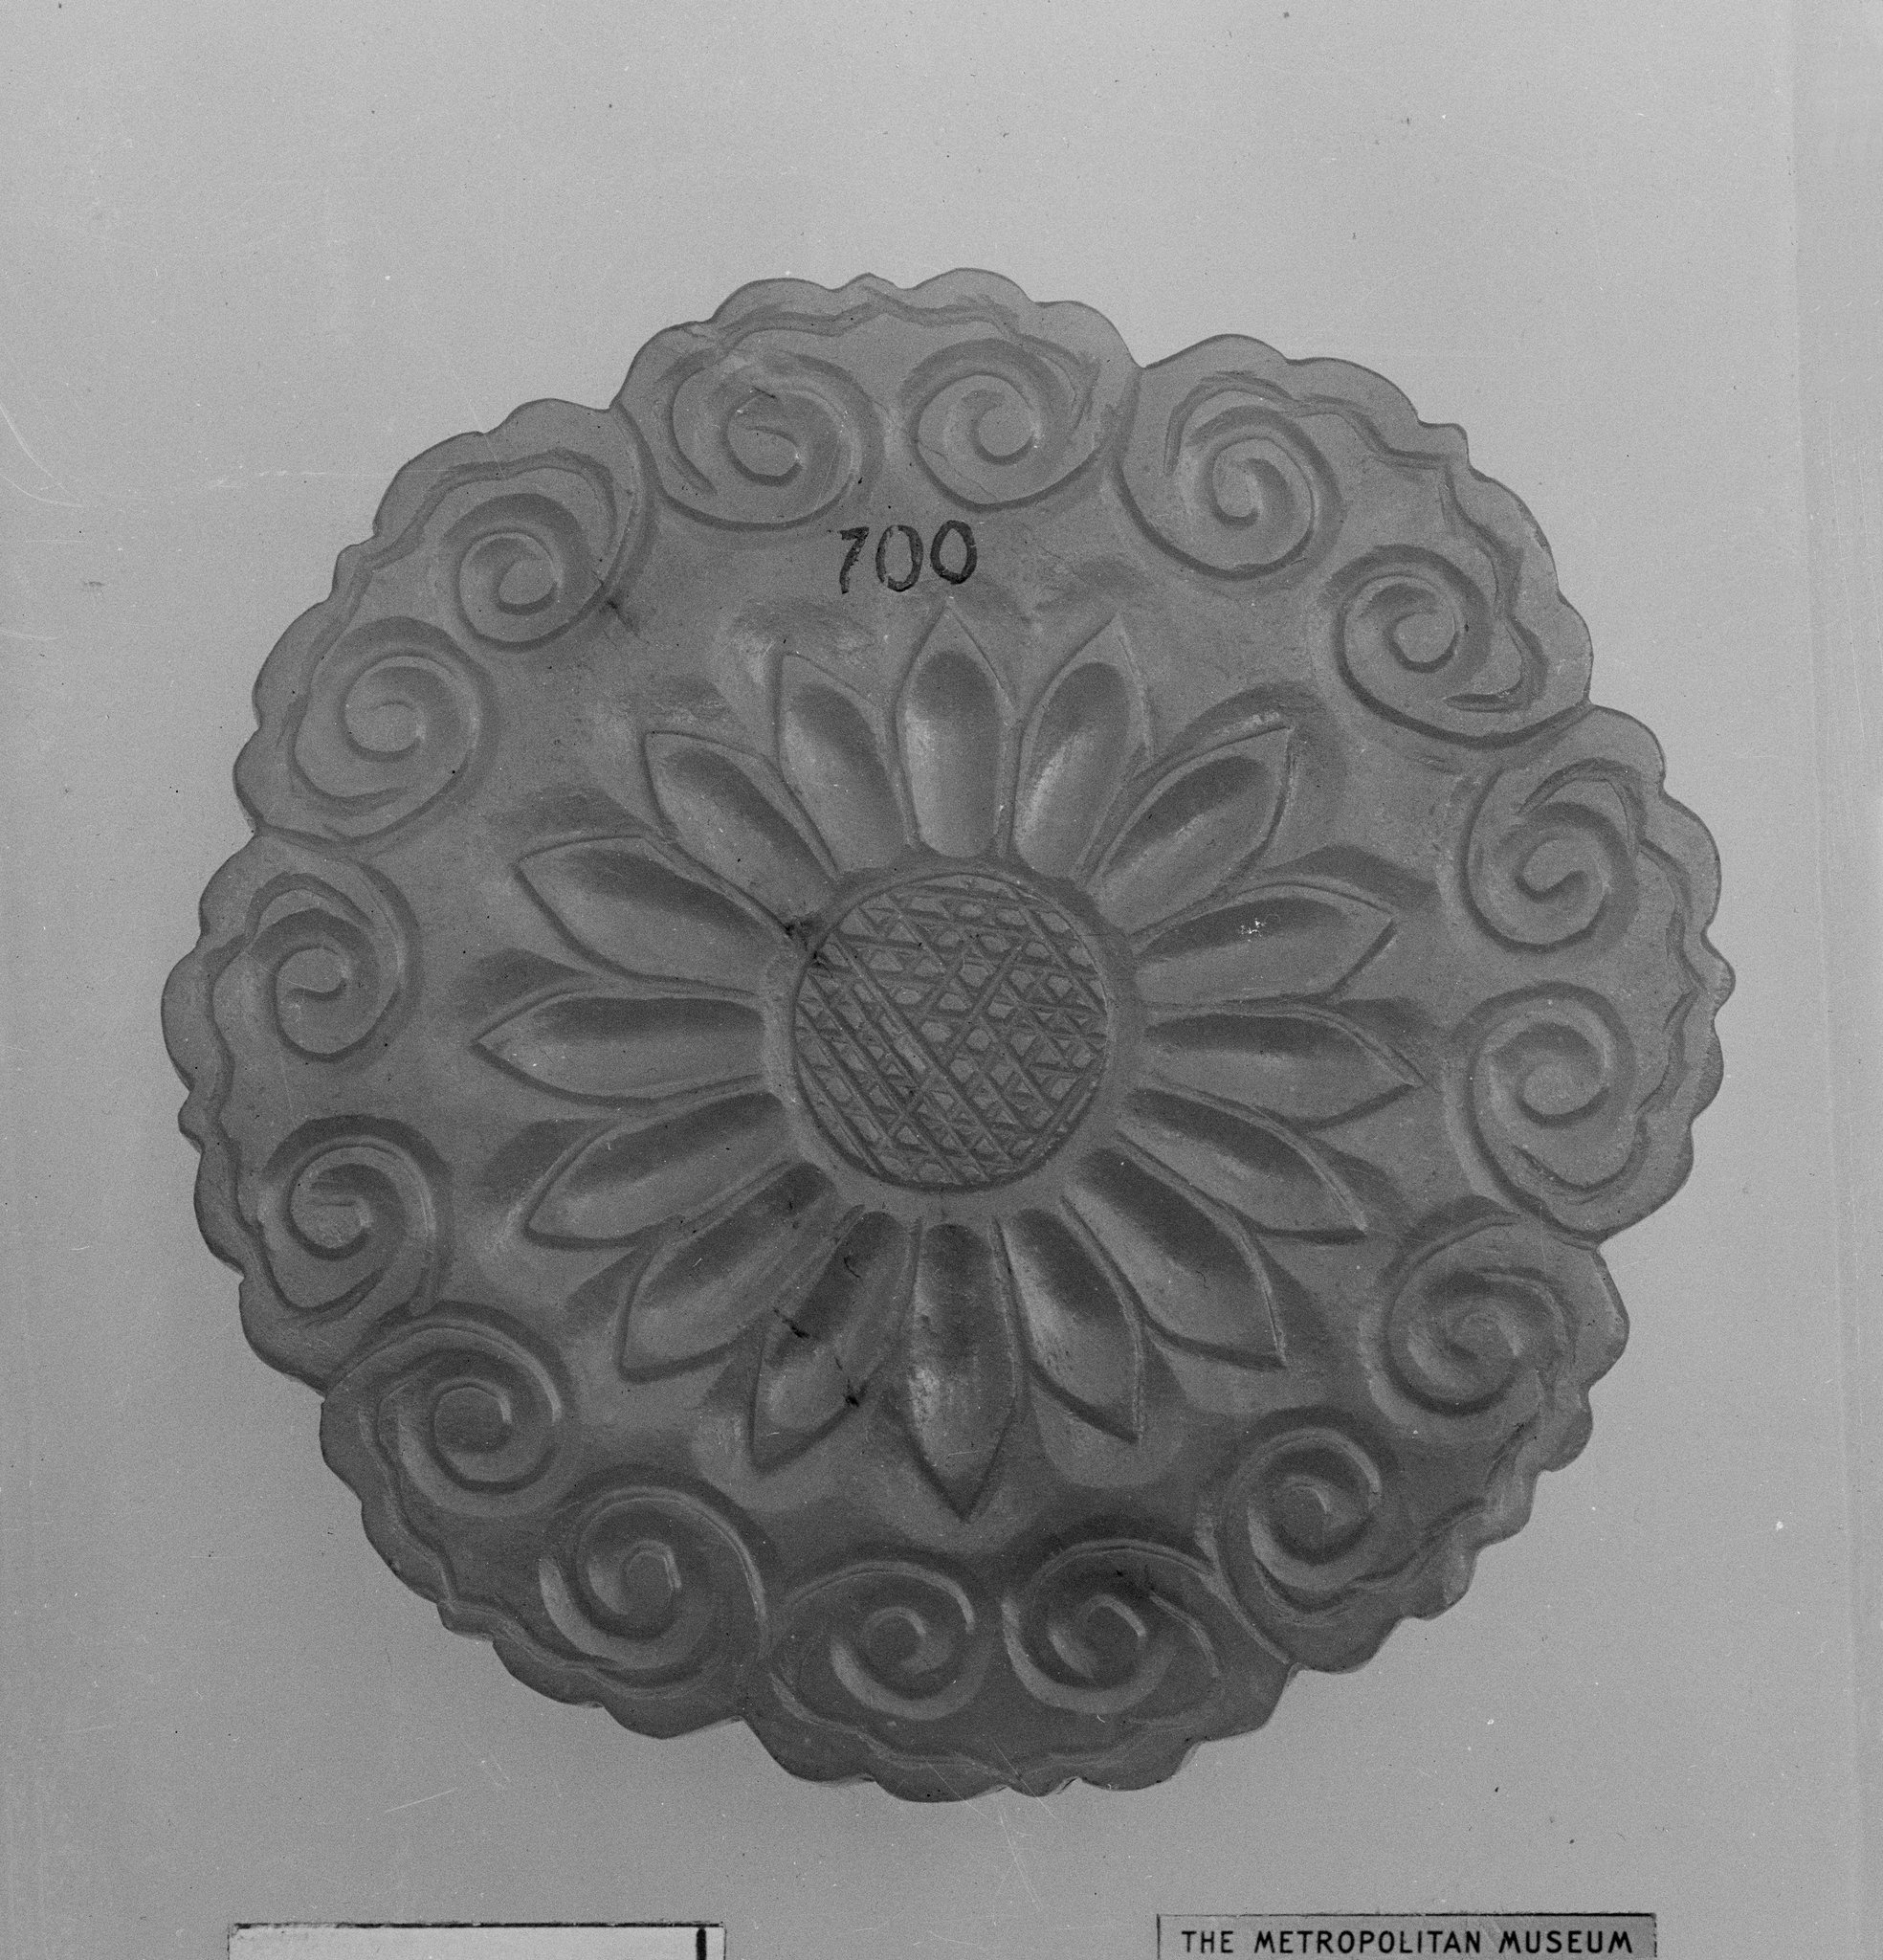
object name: disc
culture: chinese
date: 1736-1795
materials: jade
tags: flowers